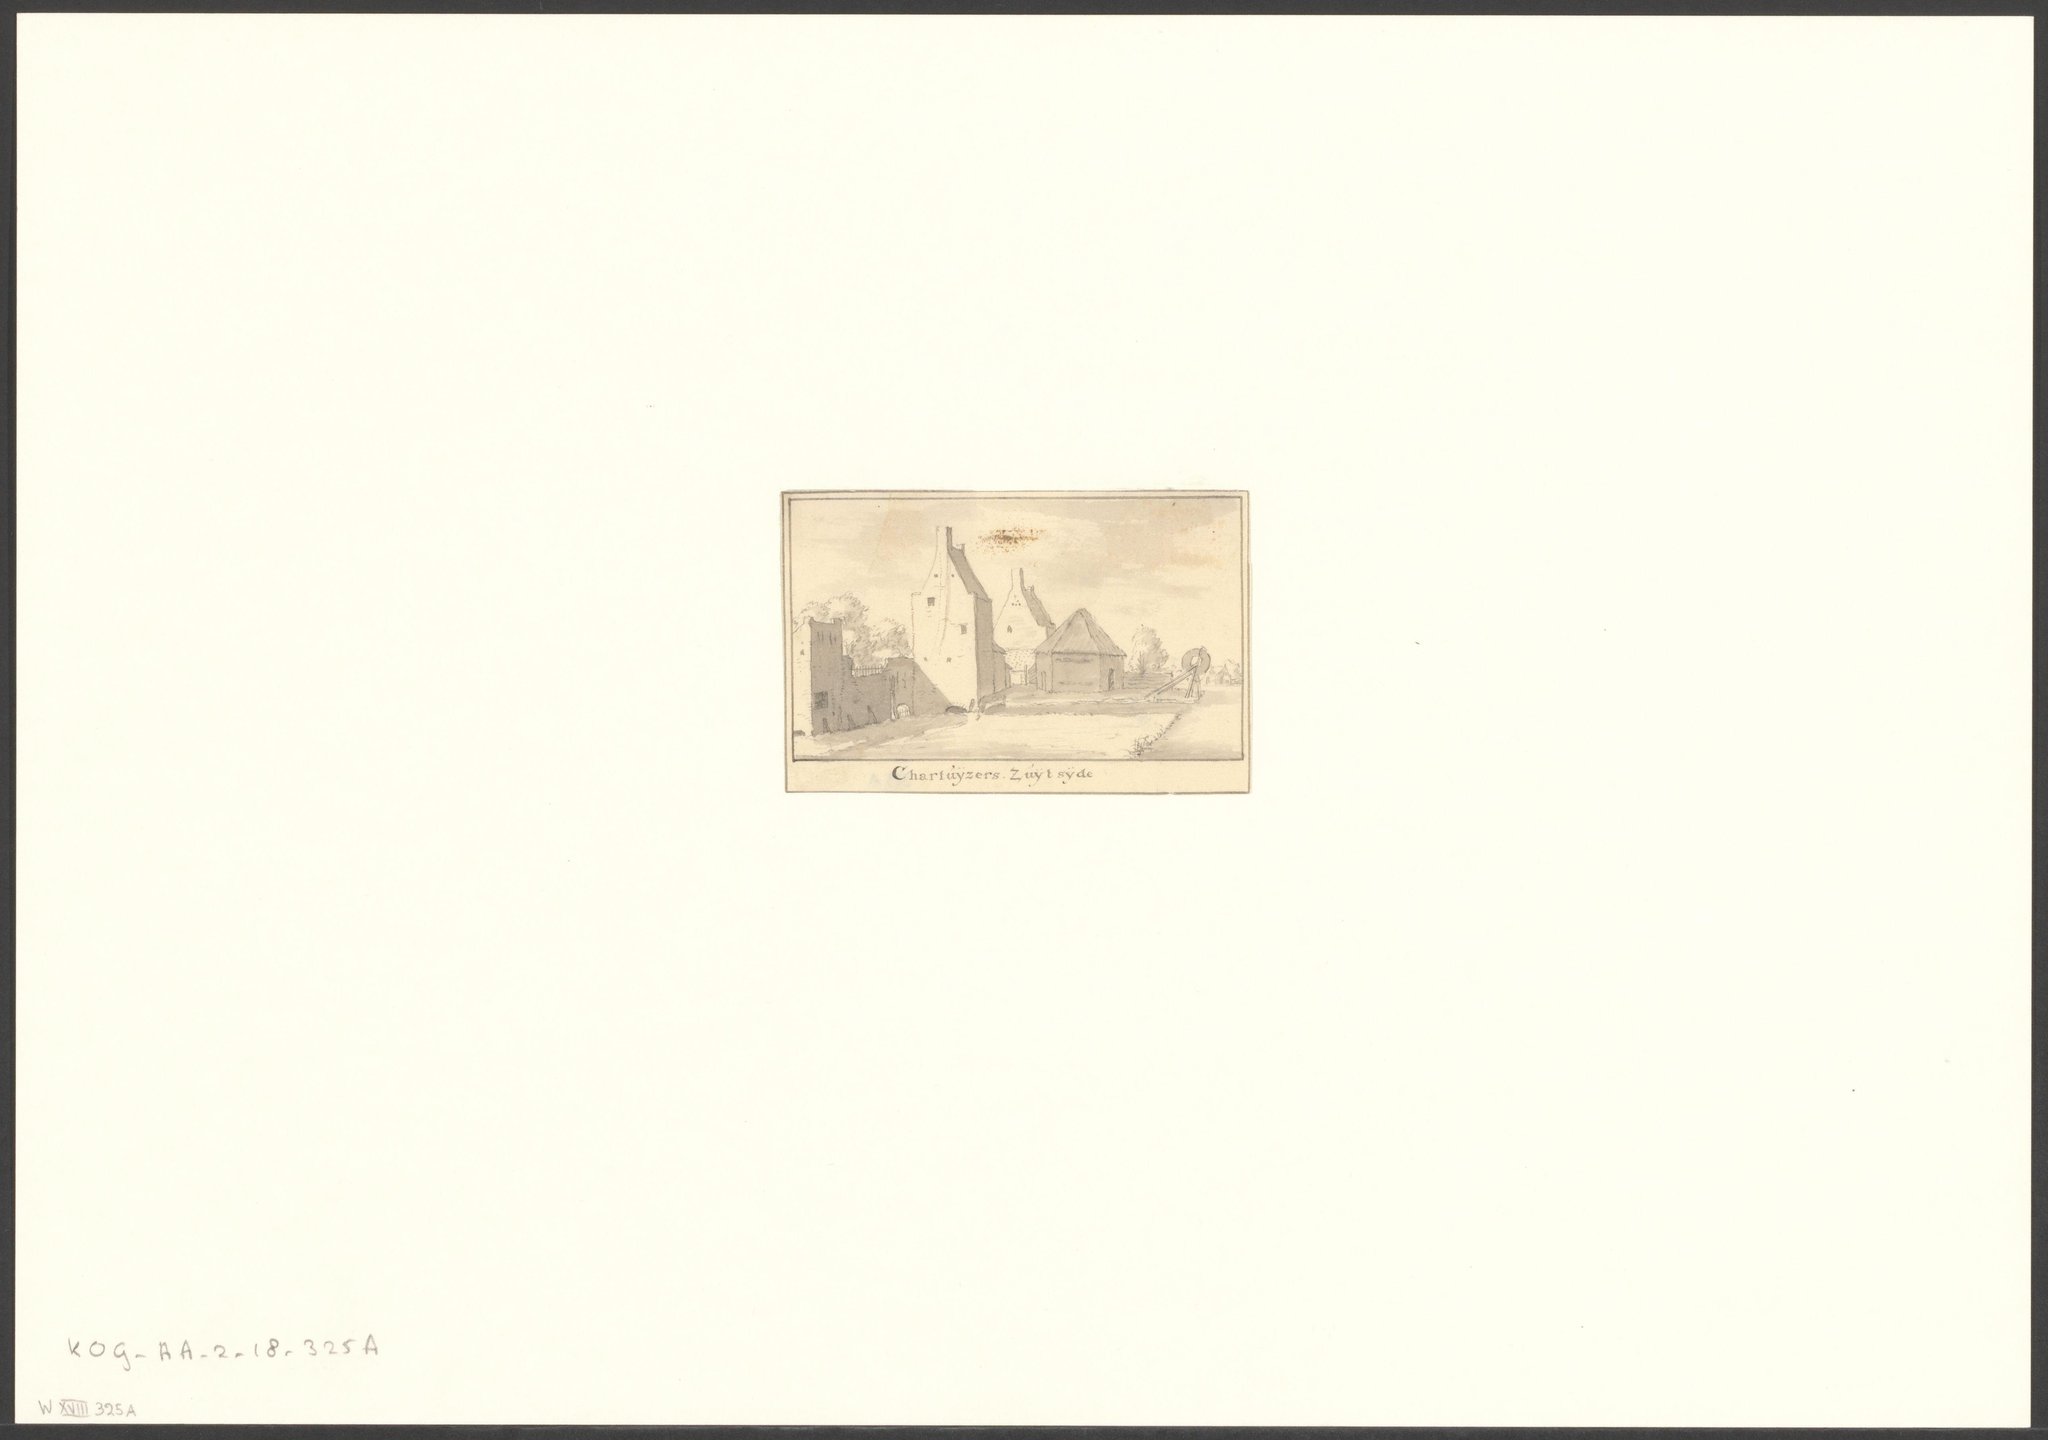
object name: drawing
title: Gezicht op de zuidzijde van het Kartuizerklooster te Amsterdam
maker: claes jansz. visscher (ii)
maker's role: draughtsman, print maker, publisher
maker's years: 1586-1652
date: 1596-1652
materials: ink, paper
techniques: brush, pen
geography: amsterdam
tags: city-view in general; 'veduta', abbey, monastery, convent ~ roman catholic church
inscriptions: inscription: ‘Chartuijzers Zuijt sijde’, collector's mark: Lugt 800a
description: Tekening binnen de Atlas Van Eck ingedeeld op wijknummer 18.